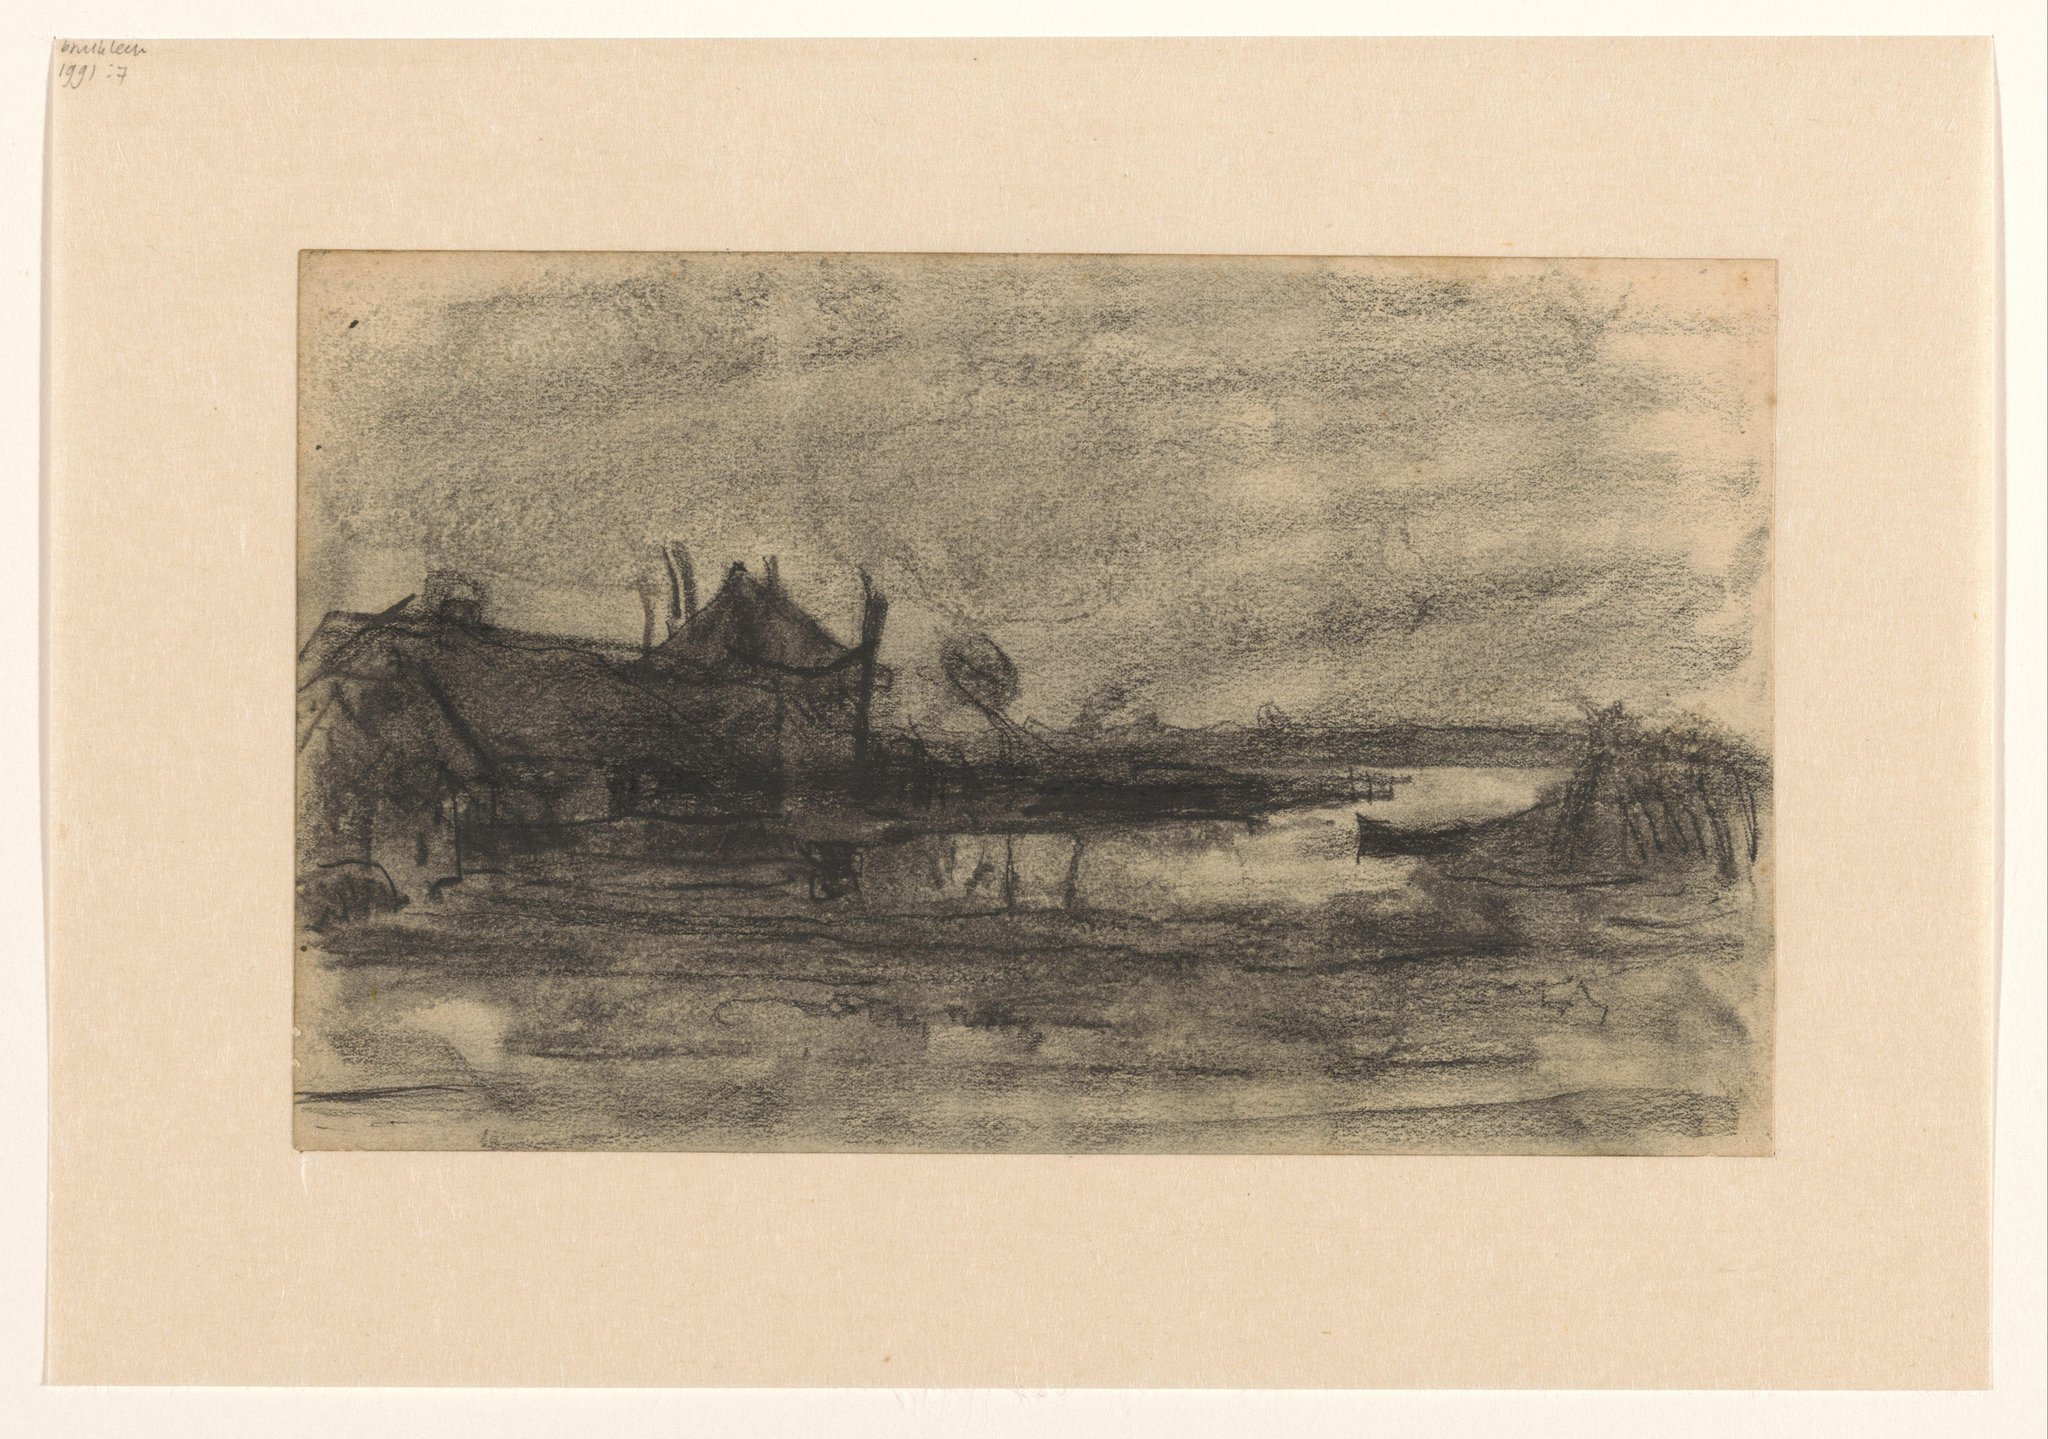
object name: drawing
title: Boerderij bij een meertje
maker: floris verster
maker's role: draughtsman, painter, print maker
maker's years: 1861-1927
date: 1885-1890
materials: chalk, paper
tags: farm or solitary house in landscape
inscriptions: signature and date: ‘Uit een schetsboek van Floris Verster, ±1888, H.P.B.’